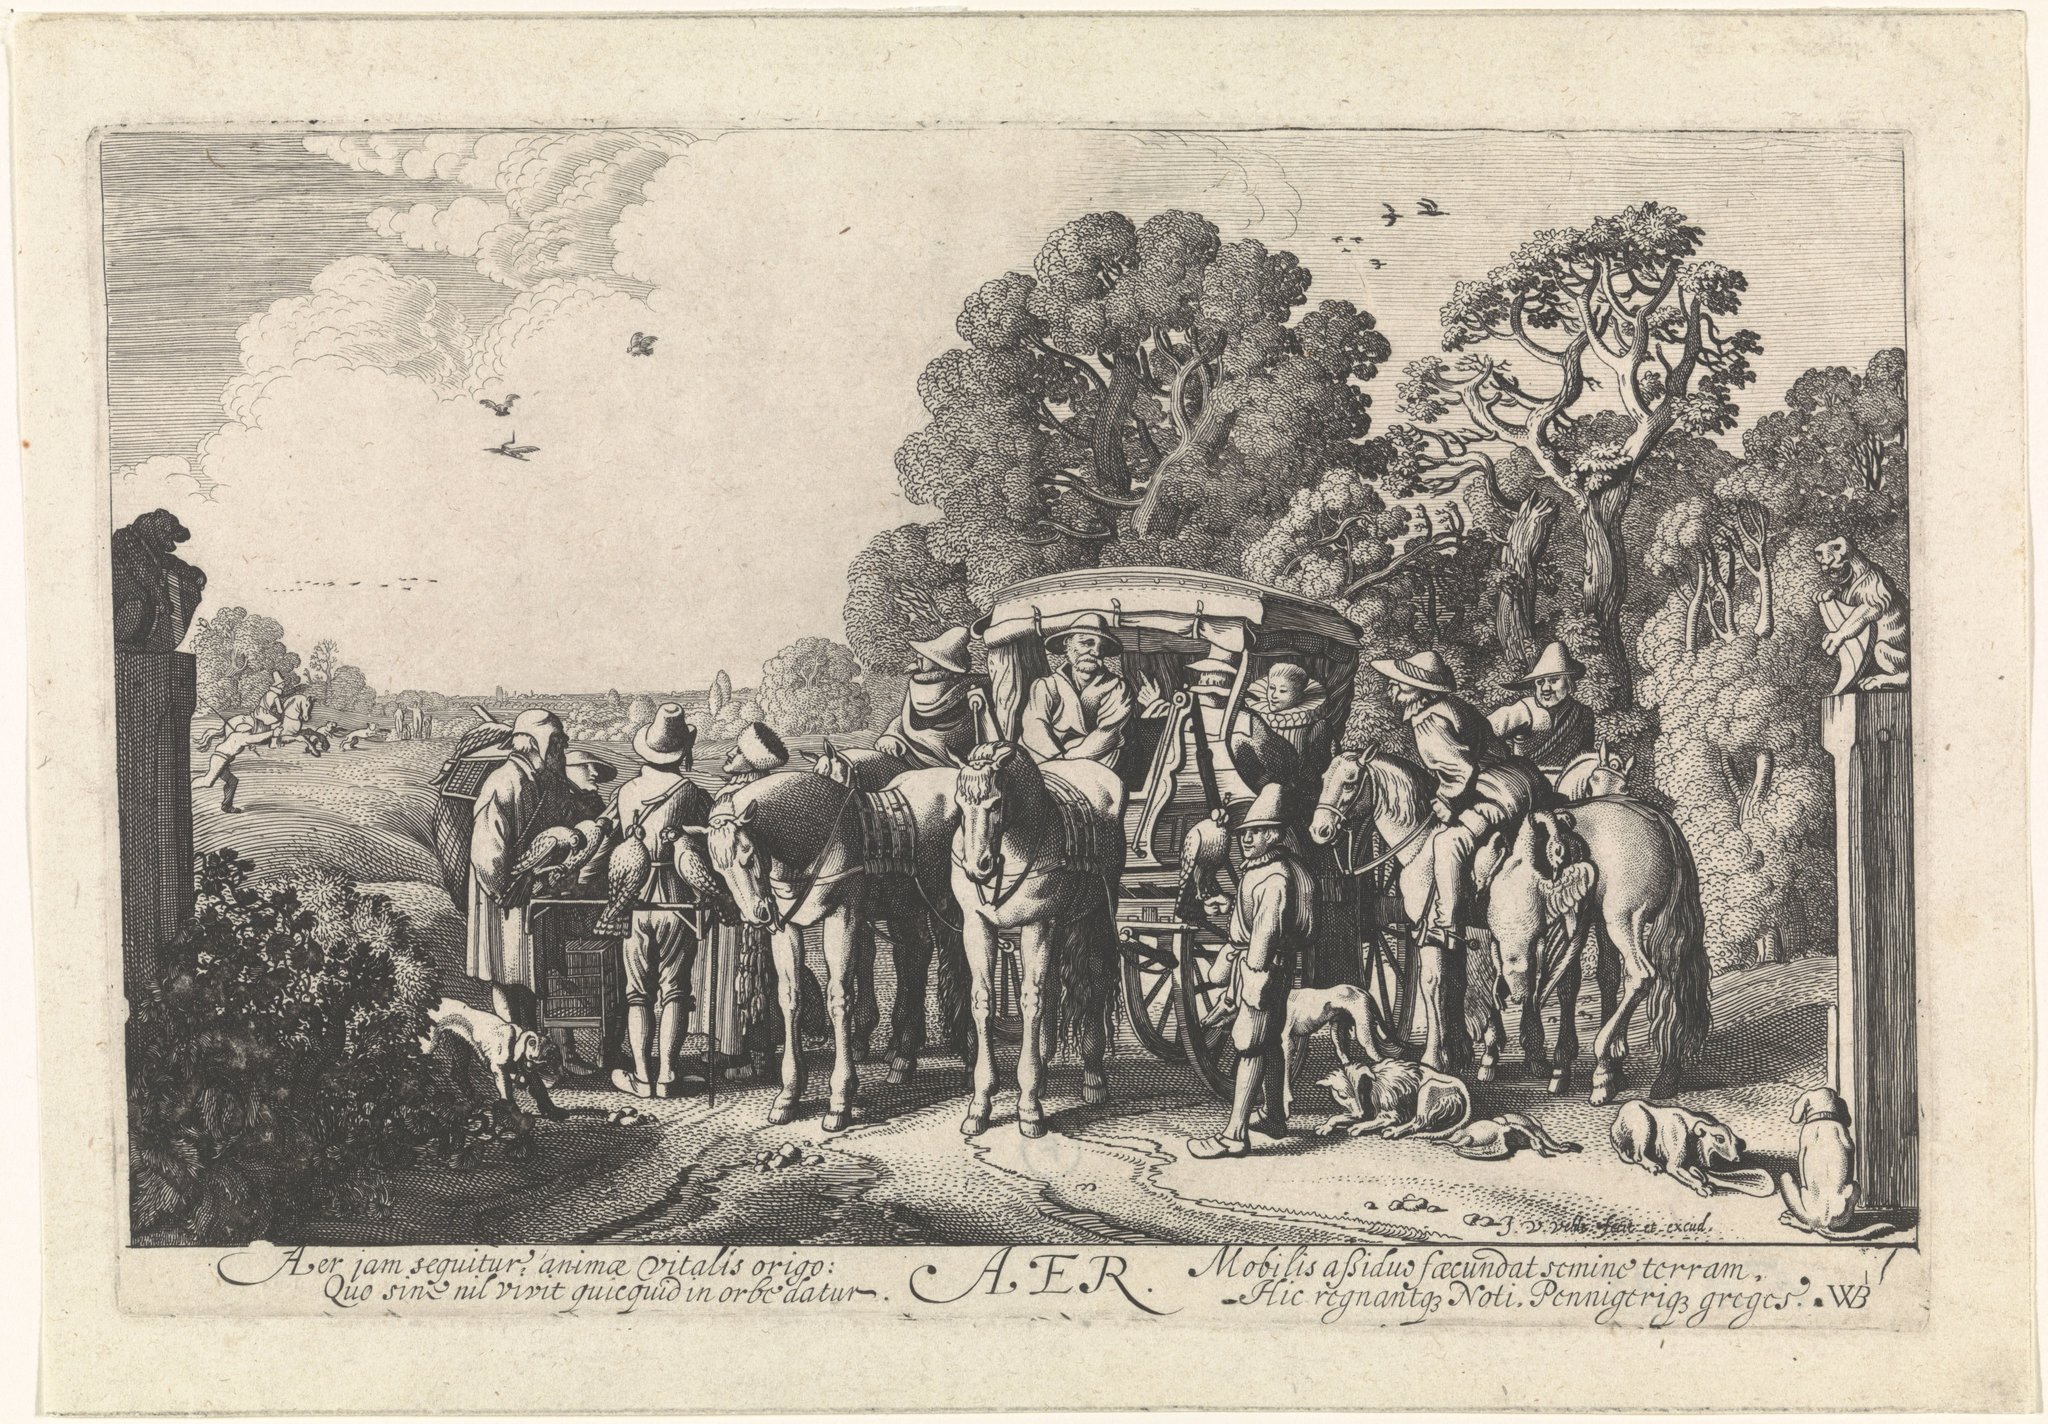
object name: print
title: De vier elementen A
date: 1603-1641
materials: paper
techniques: engraving, etching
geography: northern netherlands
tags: predatory birds: falcon, hunting, chase, air (one of the four elements), game, hunted animals, bird hunting, four-wheeled vehicle drawn by two animals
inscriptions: collector's mark: Lugt 964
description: Landschap met figuren tijdens een valkenjacht voorstellende het element lucht. Op een landweg staat een stilstaande reiskoets met twee paarden ervoor. Een groep valkeniers eromheen. Tweede prent uit een serie van vier met landschappen als verbeeldingen van de vier elementen.